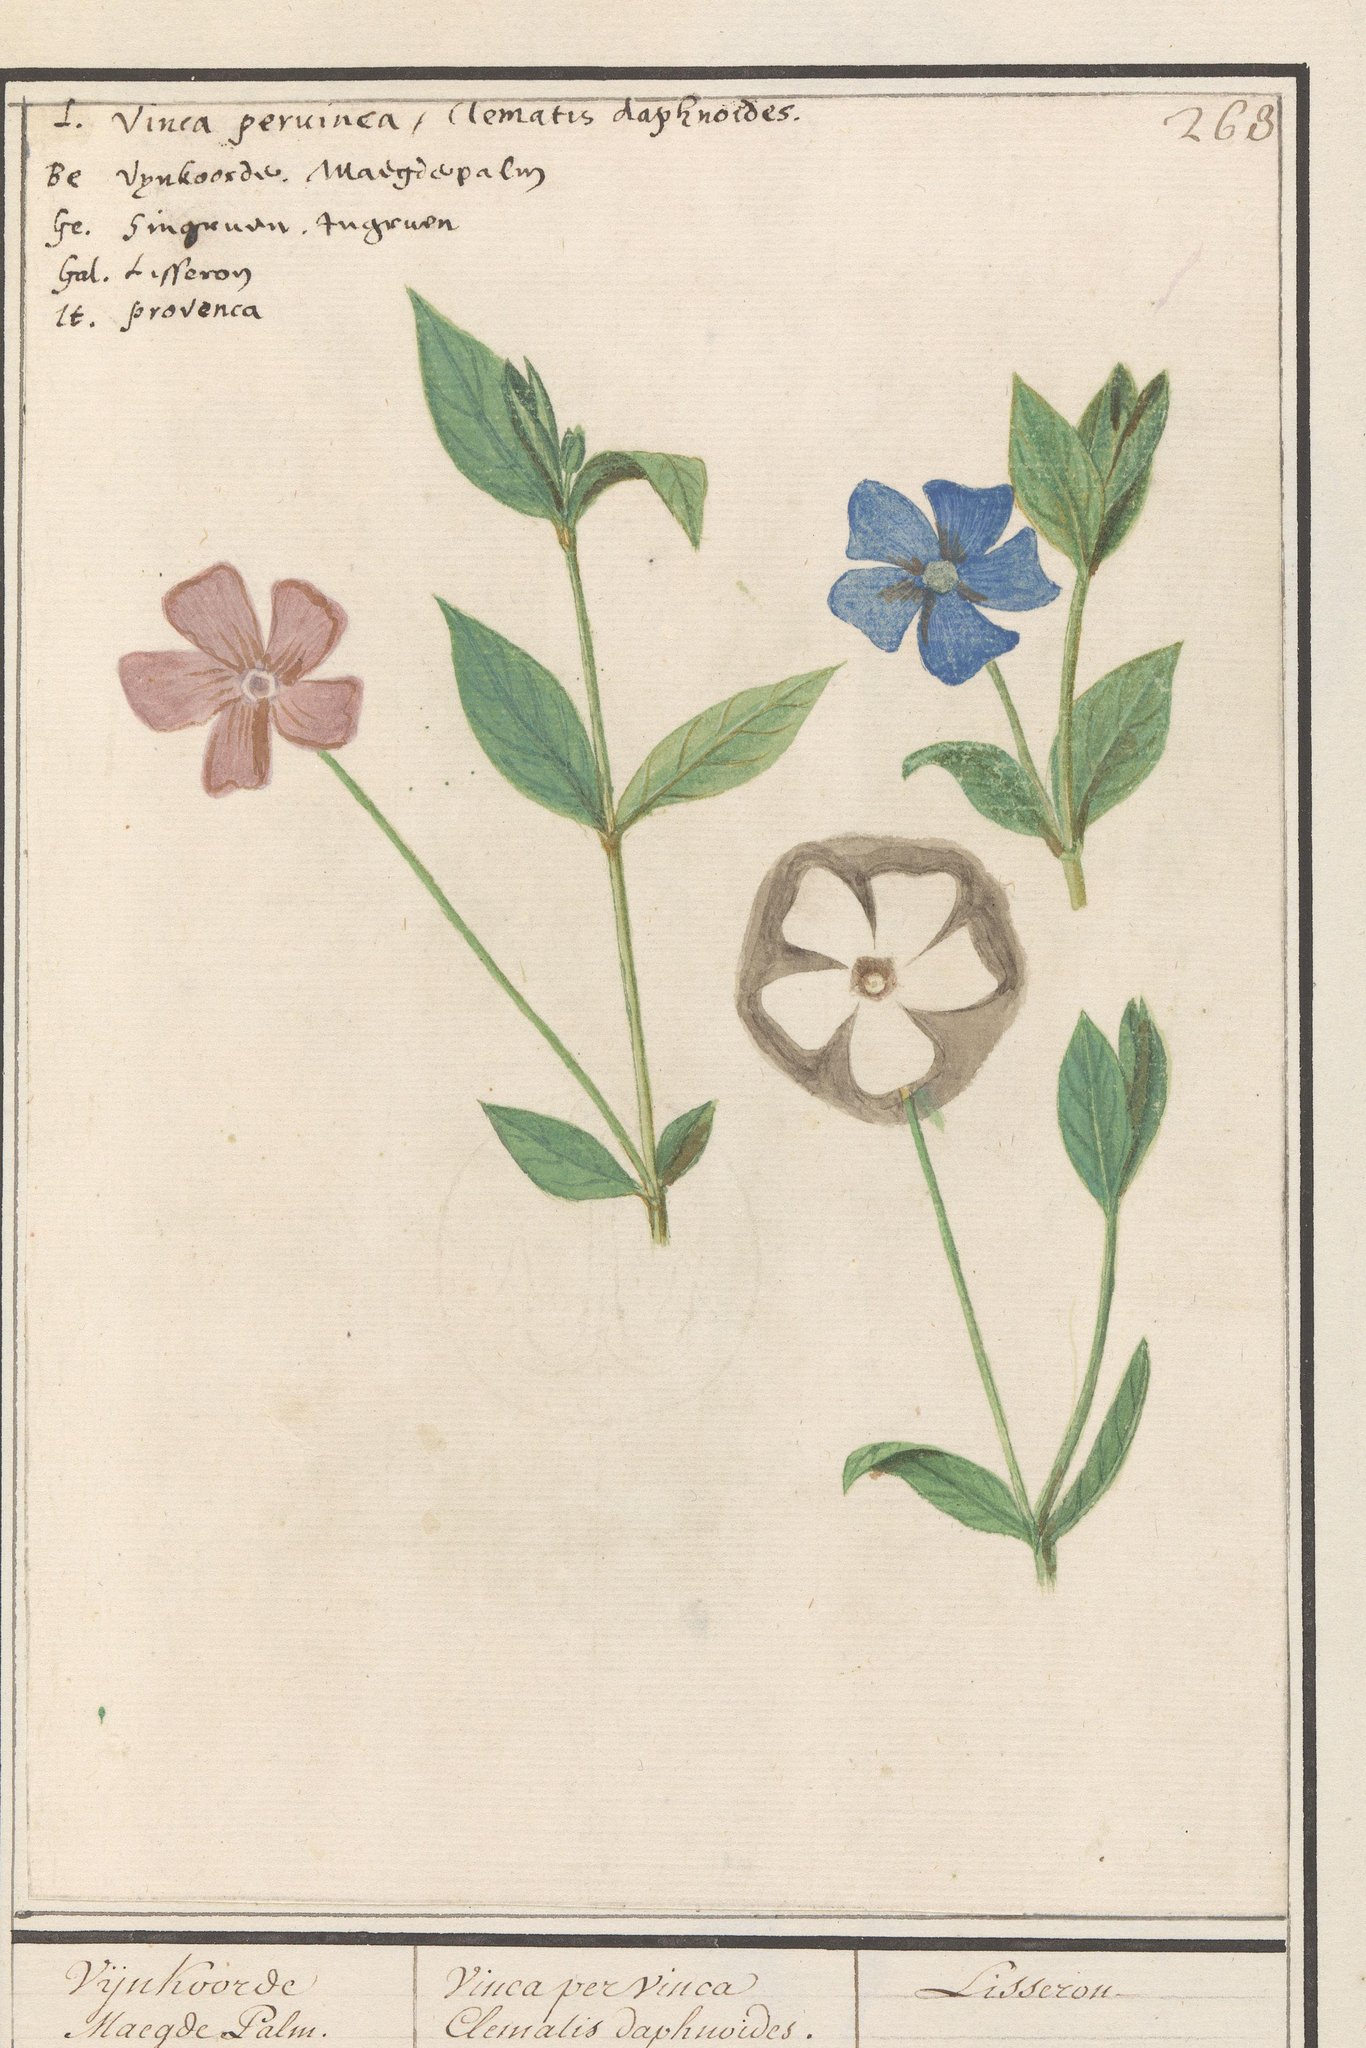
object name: drawing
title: Vijnkoorde Maegde Palm. / Vinca per vinca Clematis daphnoides. / Lisseron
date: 1596-1610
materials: chalk, paint, ink, paper, watercolor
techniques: brush, pen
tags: flowers: vinca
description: Maagdenpalm, in drie kleuren. Genummerd rechtsboven: 263. Rechtsbovenaan de naam in vijf talen. Onderdeel van het derde album met tekeningen van bloemen en planten. Tiende van twaalf albums met tekeningen van dieren, vogels en planten bekend rond 1600, gemaakt in opdracht van keizer Rudolf II. Met toelichting in Nederlands, Latijn en Frans.